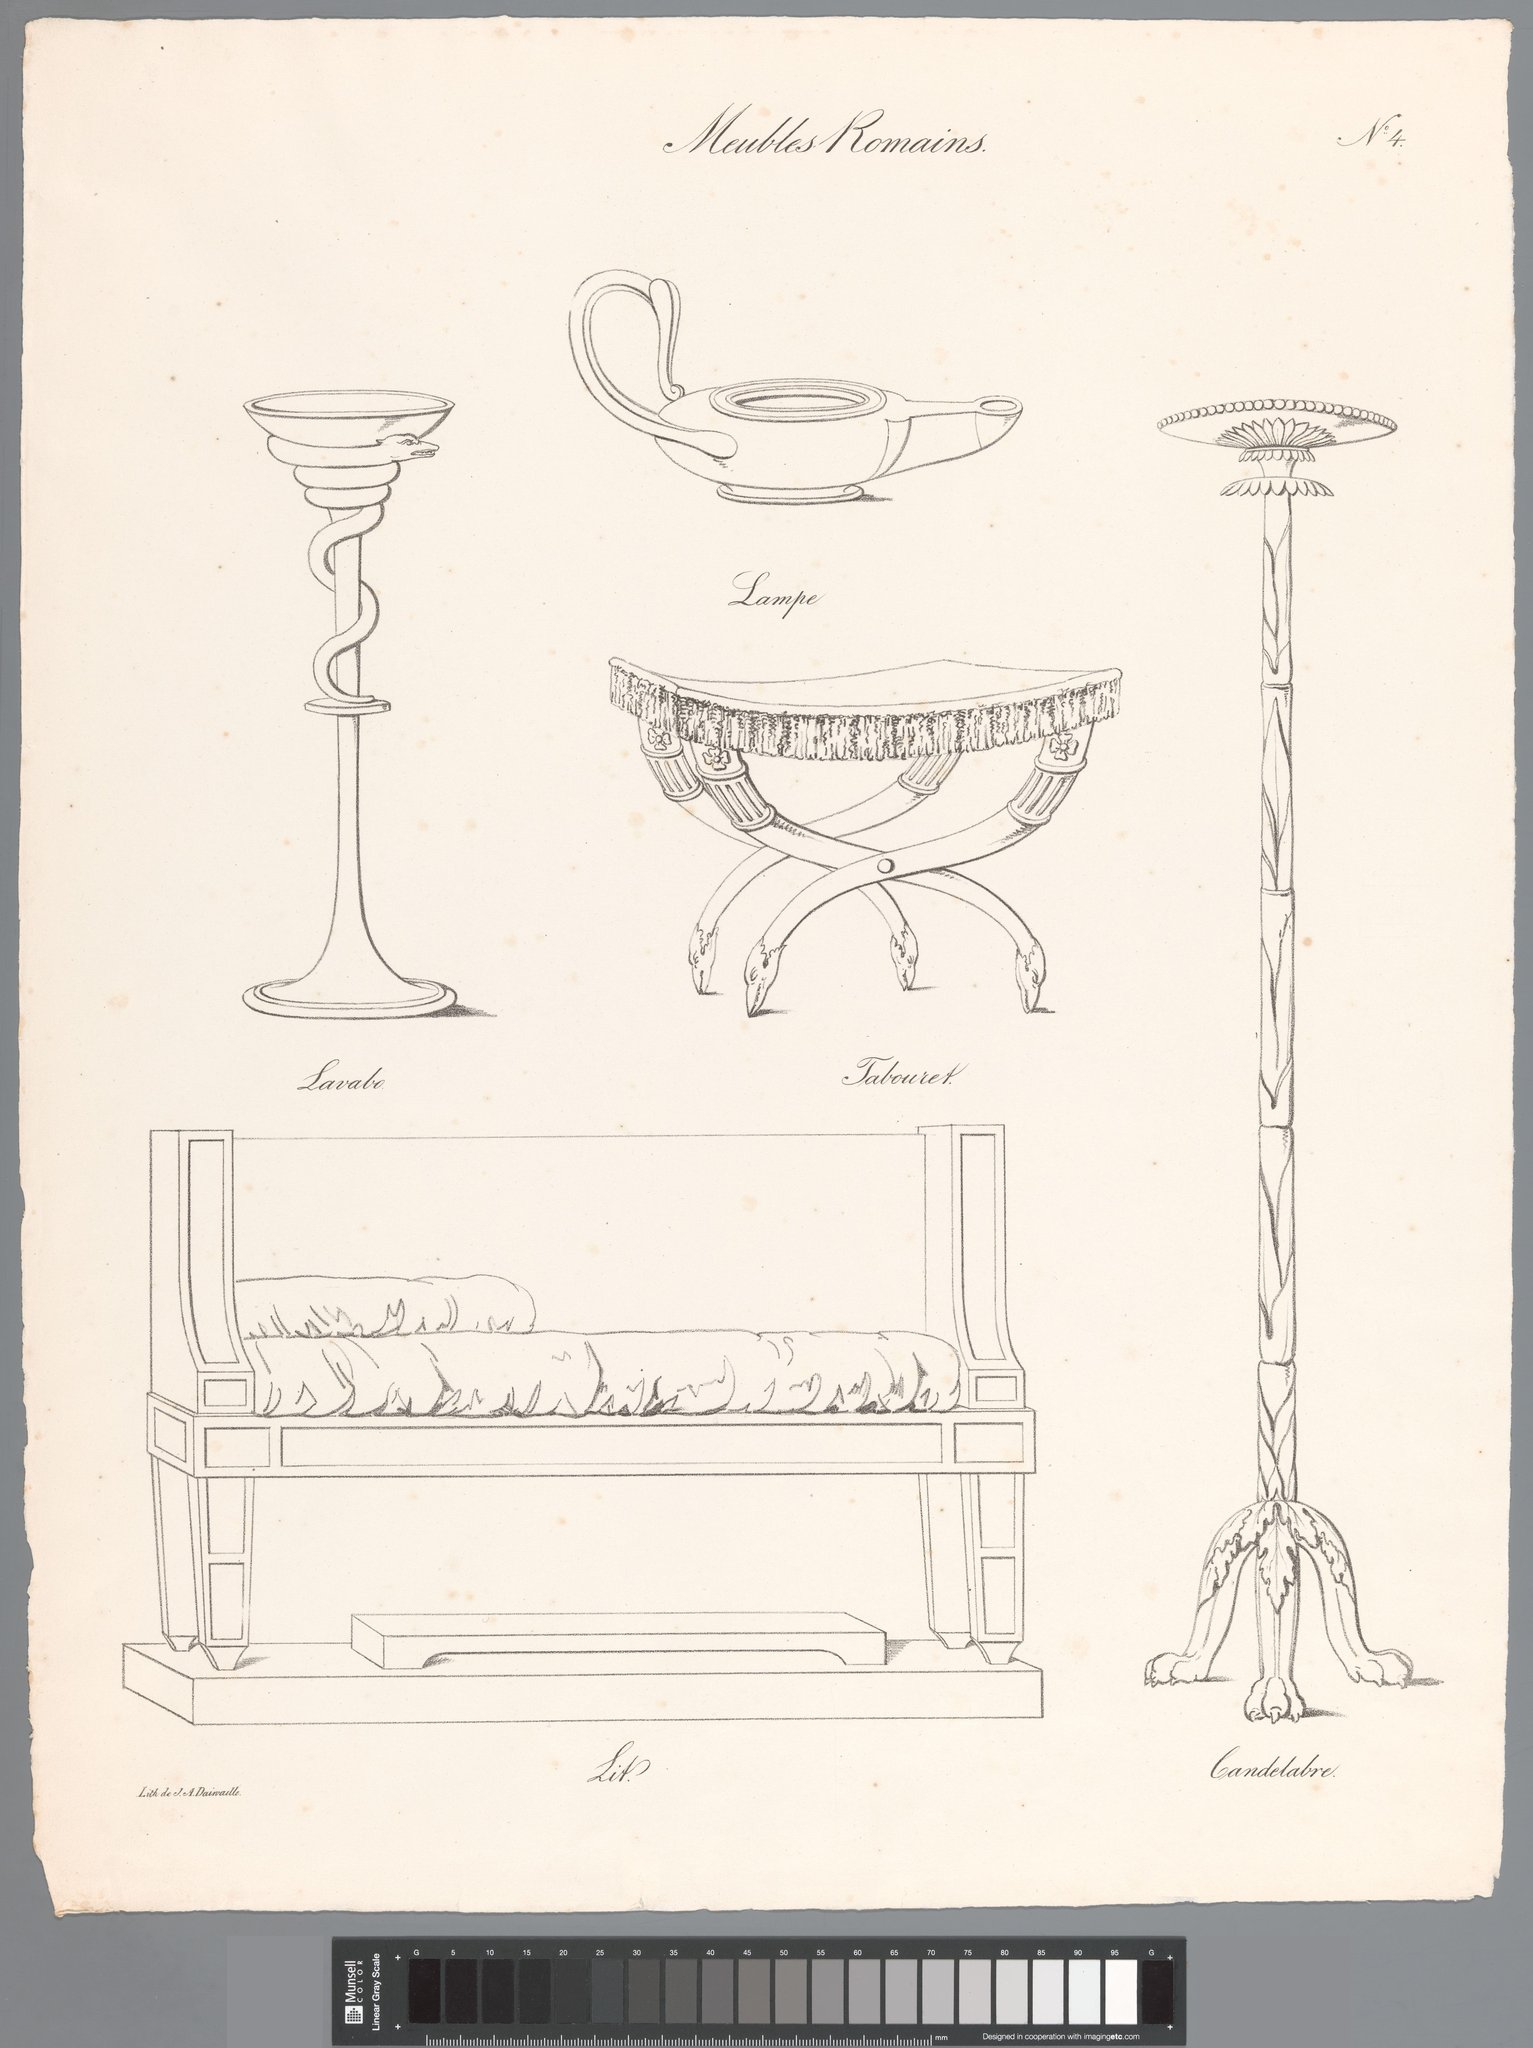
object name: print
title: Meubles Romains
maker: jean augustin daiwaille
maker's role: draughtsman, print maker, printer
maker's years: 1786-1850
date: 1820-1833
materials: paper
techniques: lithograph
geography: amsterdam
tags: fitted basin, furniture and household effects, candlestick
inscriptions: collector's mark: Lugt 2228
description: Afgebeeld zijn een olielamp, een wasbak gedecoreerd met een slang, een tabouret, een kandelaar en een bed. Genummerd rechtsboven: No. 4. Deze prent maakt deel uit van een omslag met een titelblad en zes prenten.